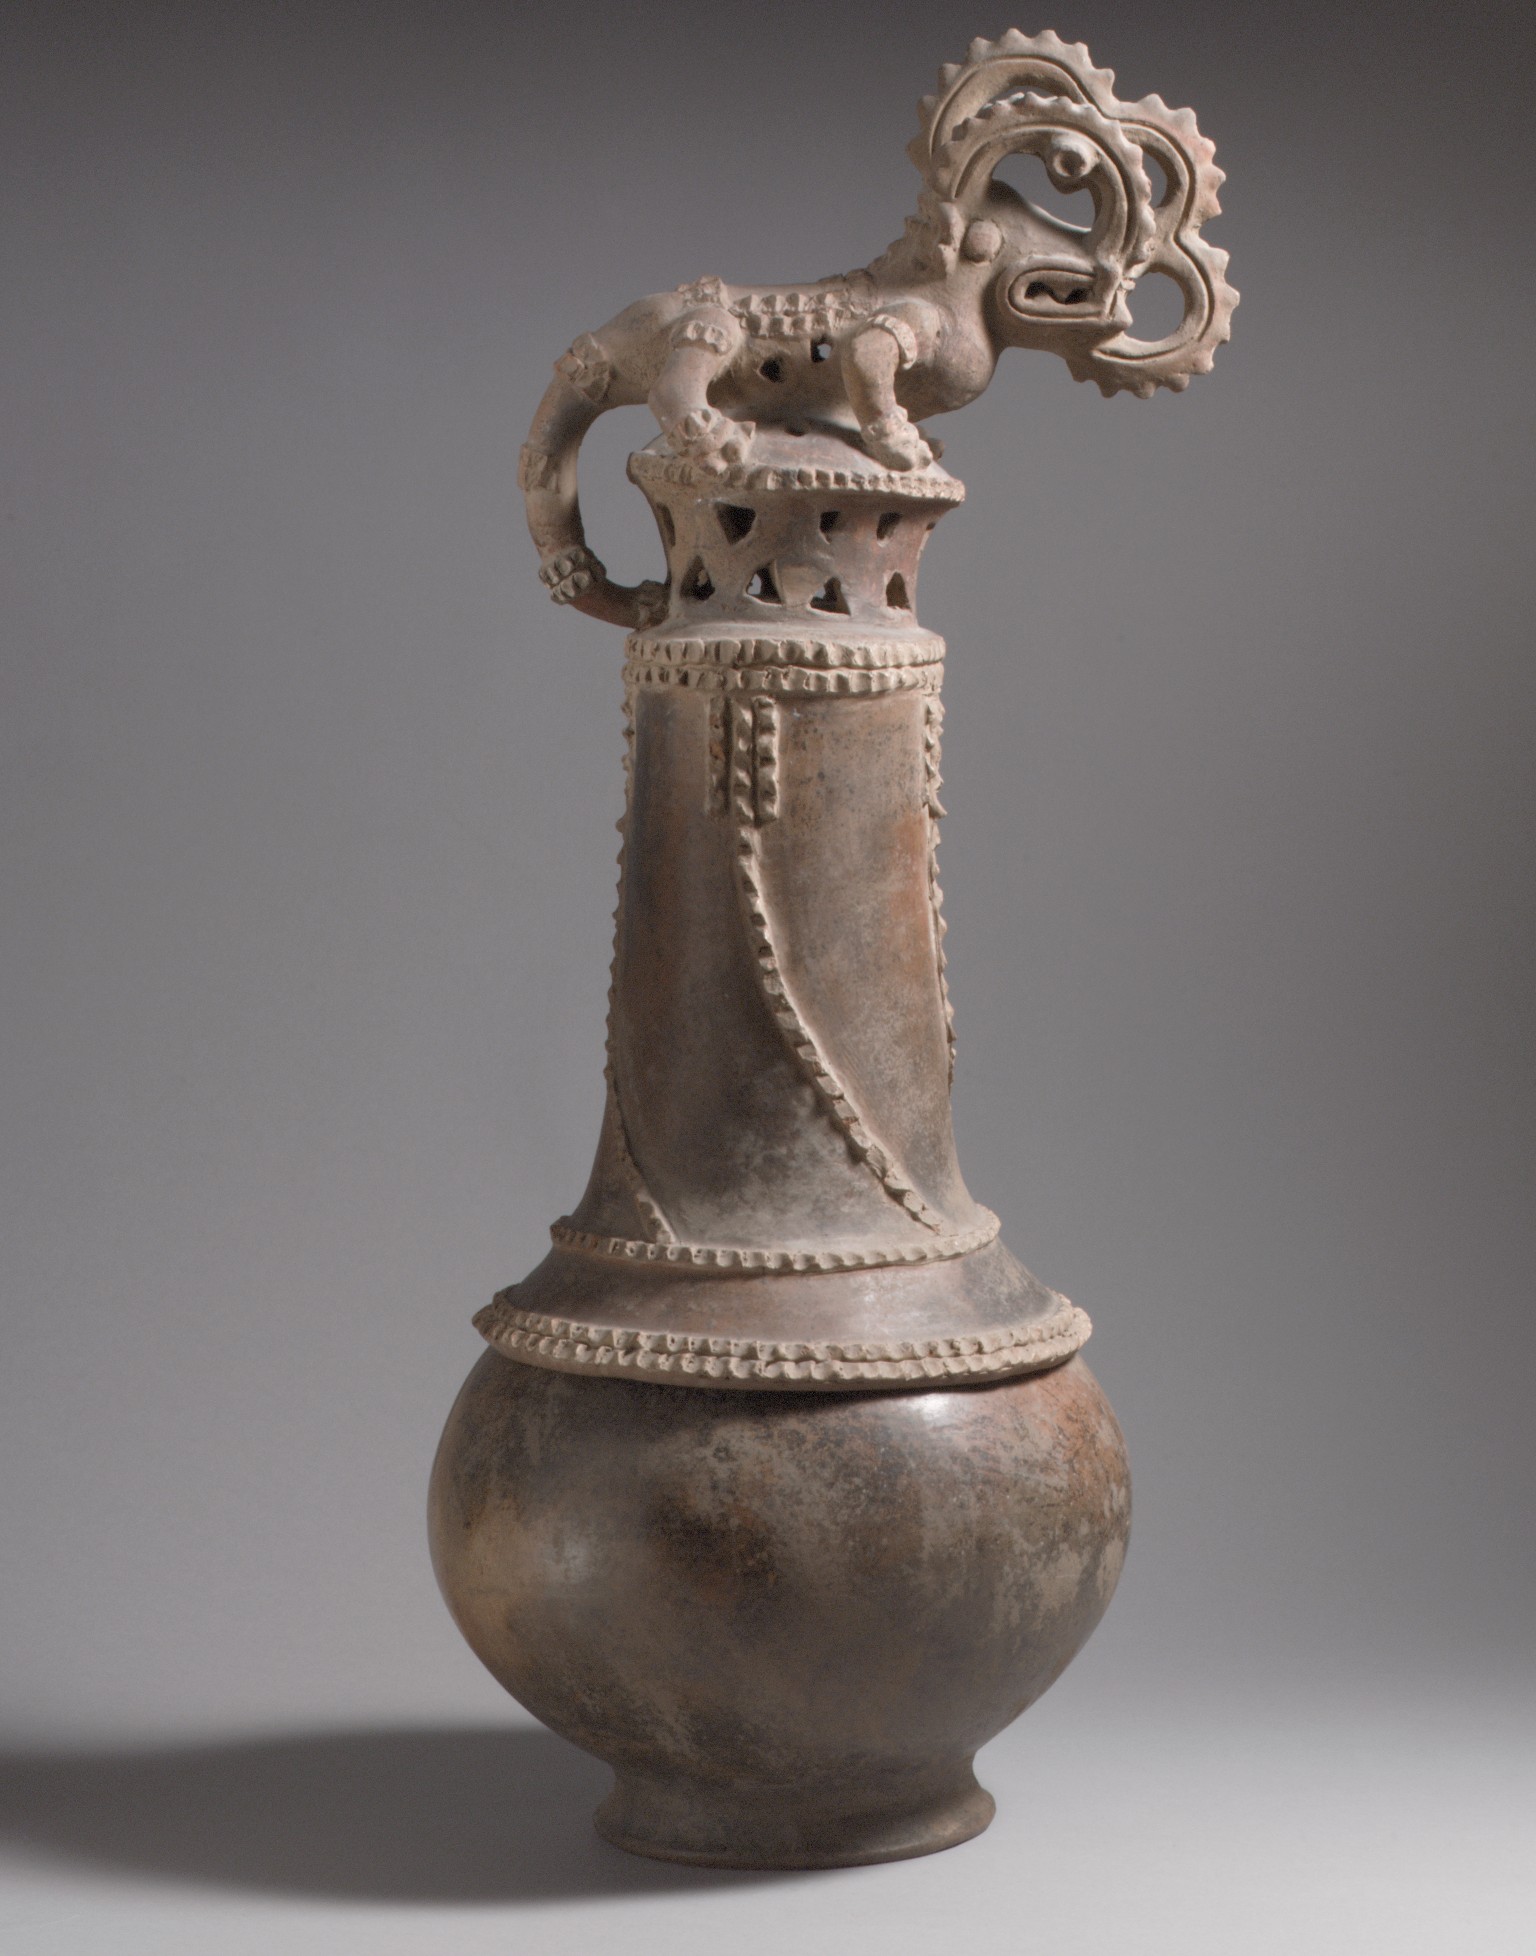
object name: censer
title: Incense Burner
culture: costa rica or nicaragua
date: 601-1200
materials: ceramic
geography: costa rica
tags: animals